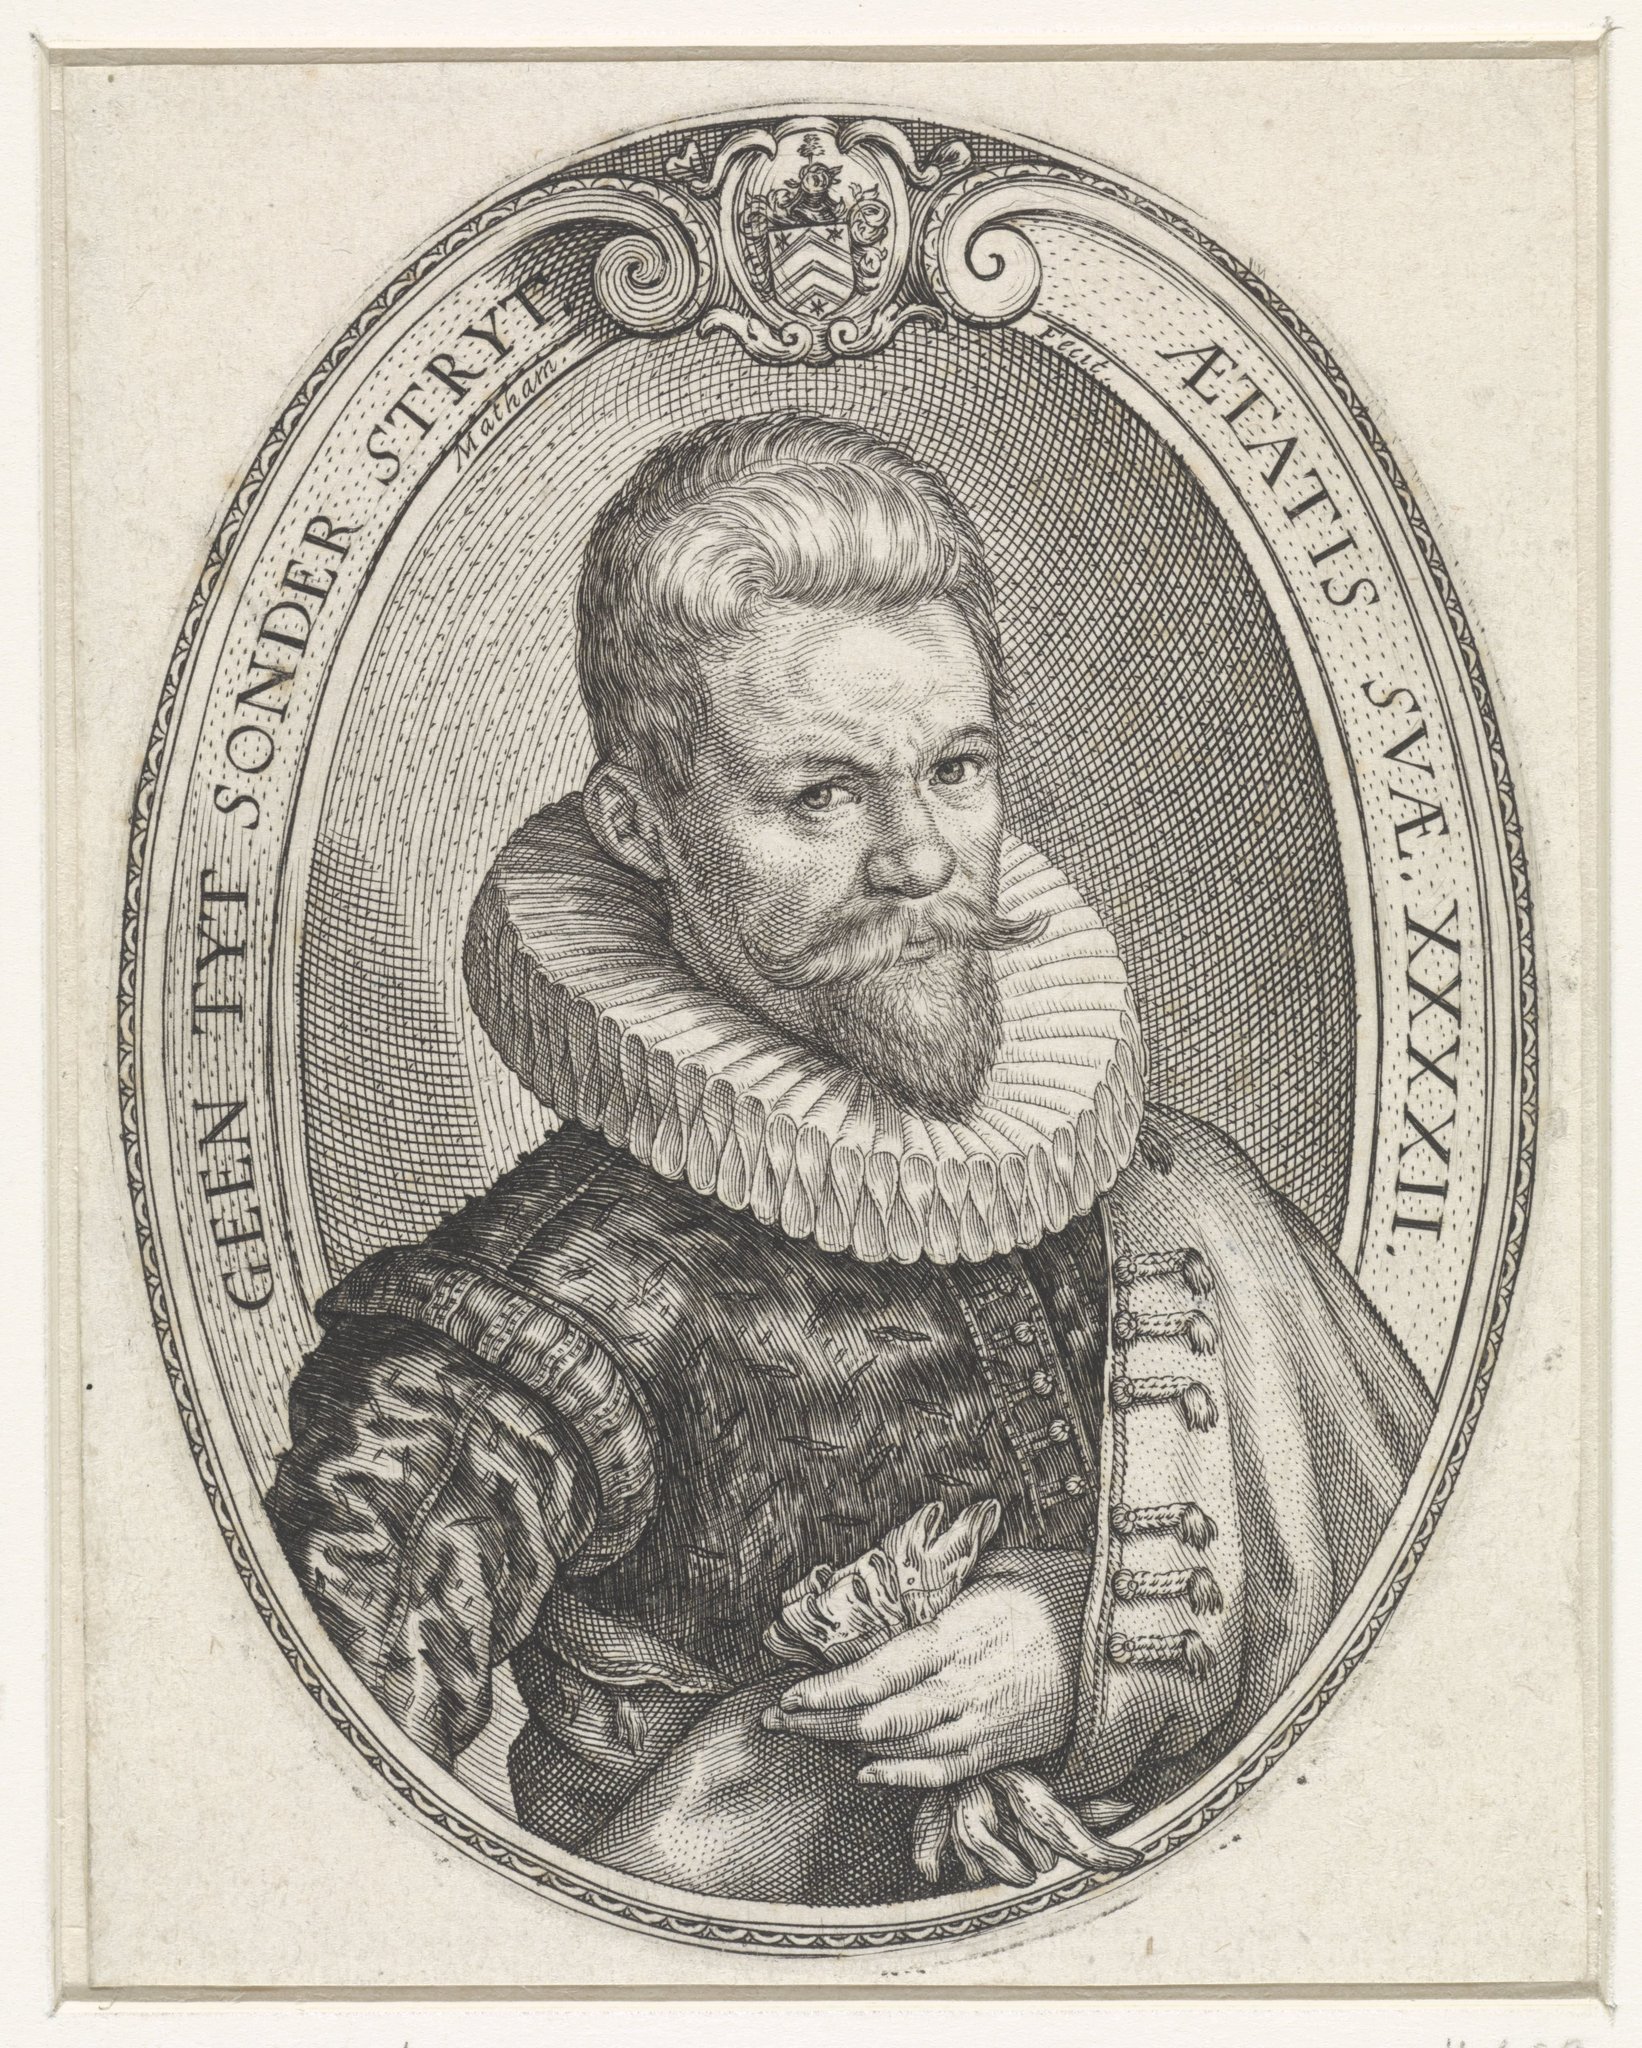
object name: print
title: Portret van een man op 42-jarige leeftijd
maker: jacob matham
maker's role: draughtsman, print maker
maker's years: 1571-1631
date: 1601-1605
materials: paper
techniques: engraving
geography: haarlem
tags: amsterdam, neck-gear ~ clothing (with name), moustache, beard, armorial bearing, heraldry, historical persons not known by name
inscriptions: inscription: ‘ook te Londen’, collector's mark: Lugt 2228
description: Portret van een man (Simon Jansz. Fortuyn?) op 42-jarige leeftijd, met snor en spitse baard, met geplooide kraag en mantel over de linkerschouder hangende. In de linkerhand heeft hij een handschoen.